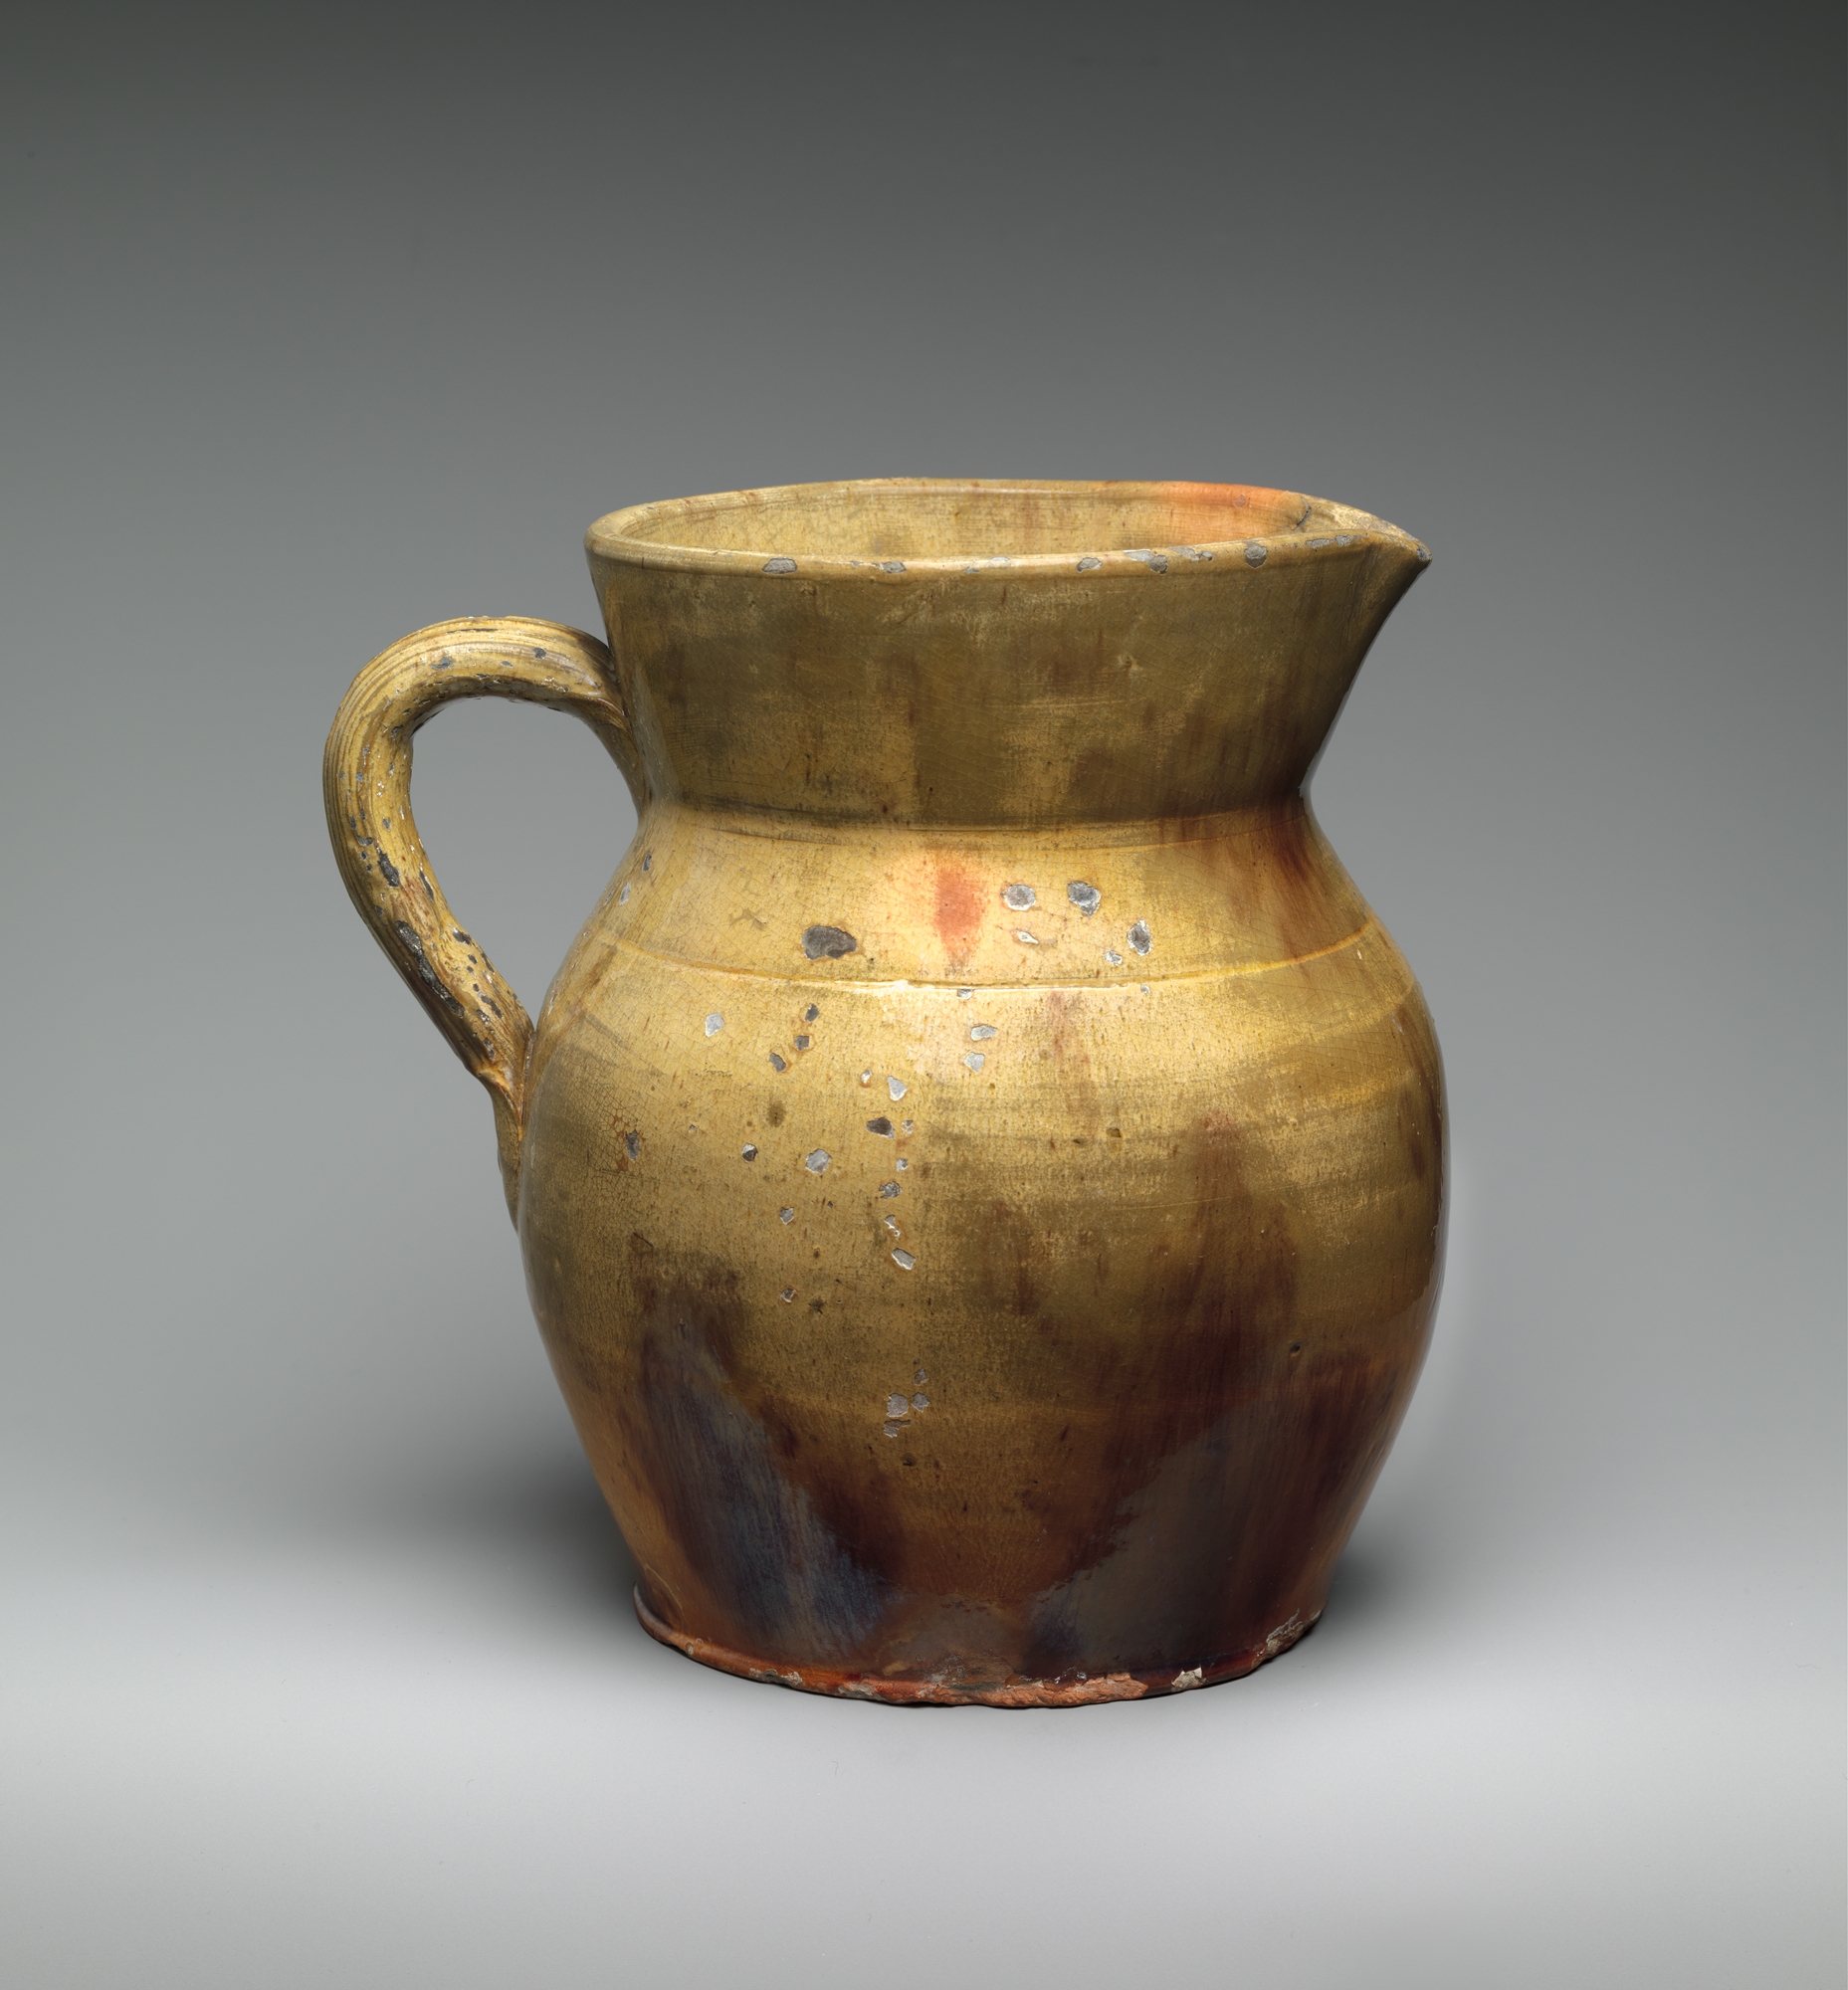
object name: pitcher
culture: american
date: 1825-1875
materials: earthenware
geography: united states